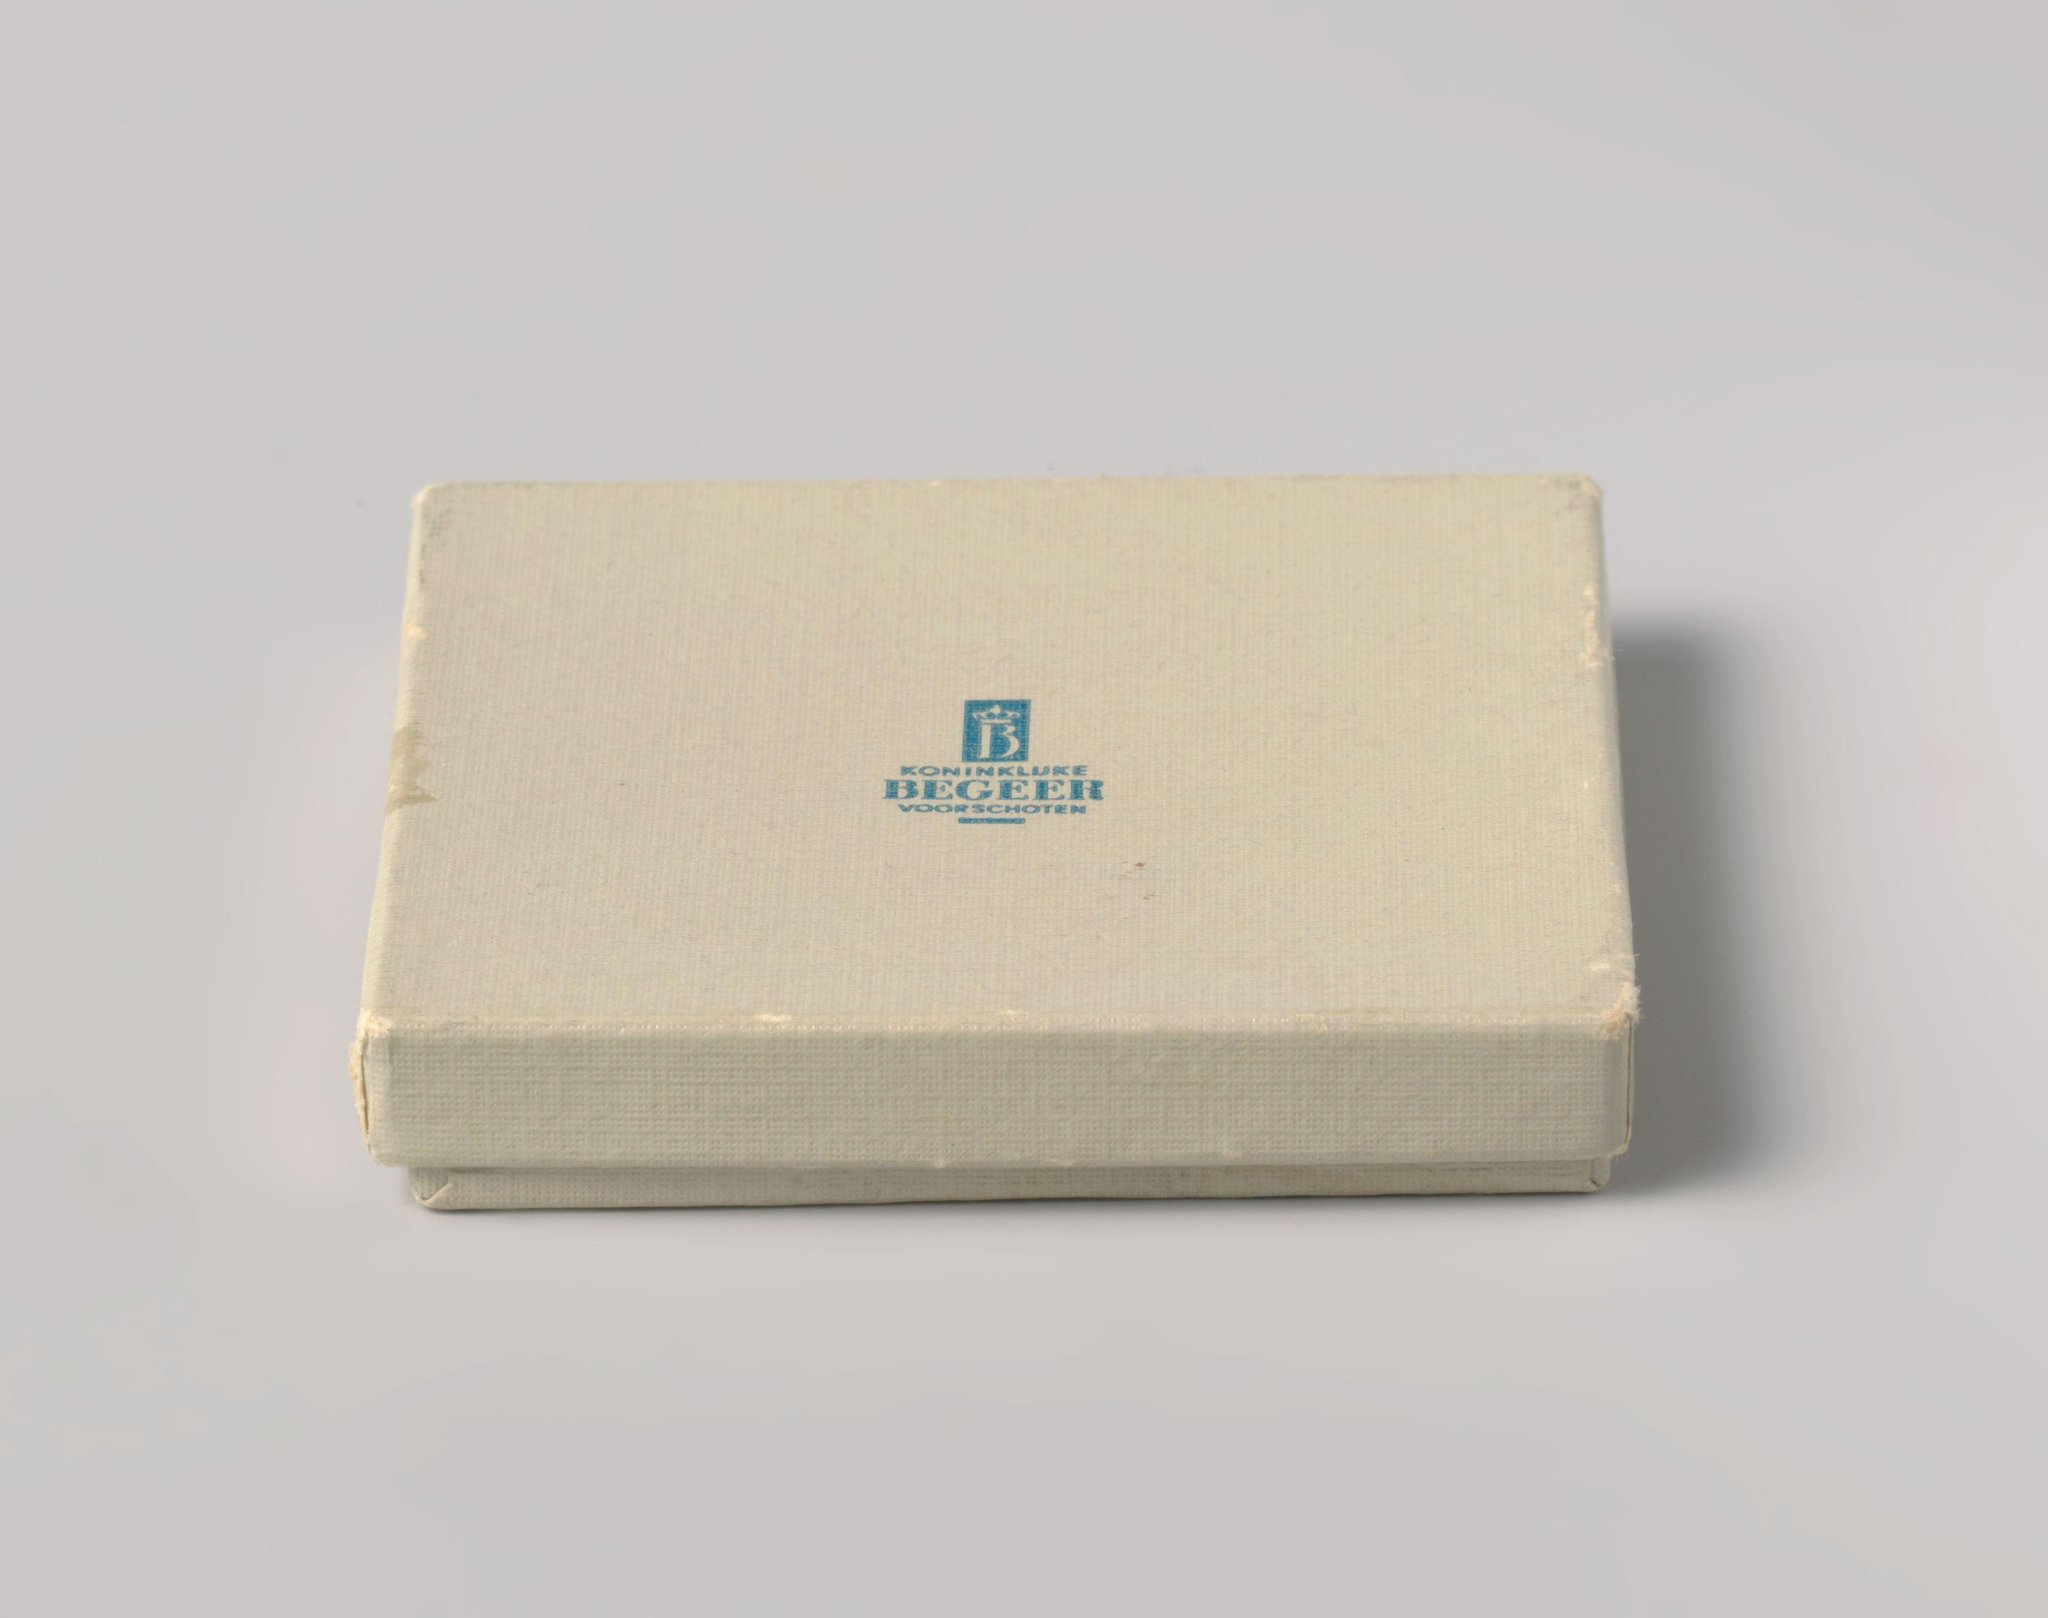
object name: medal box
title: Penningdoos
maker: Anonymous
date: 1936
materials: leather, velvet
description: Blank leren doosje. Met bijbehorende penning NG-2008-6-1.